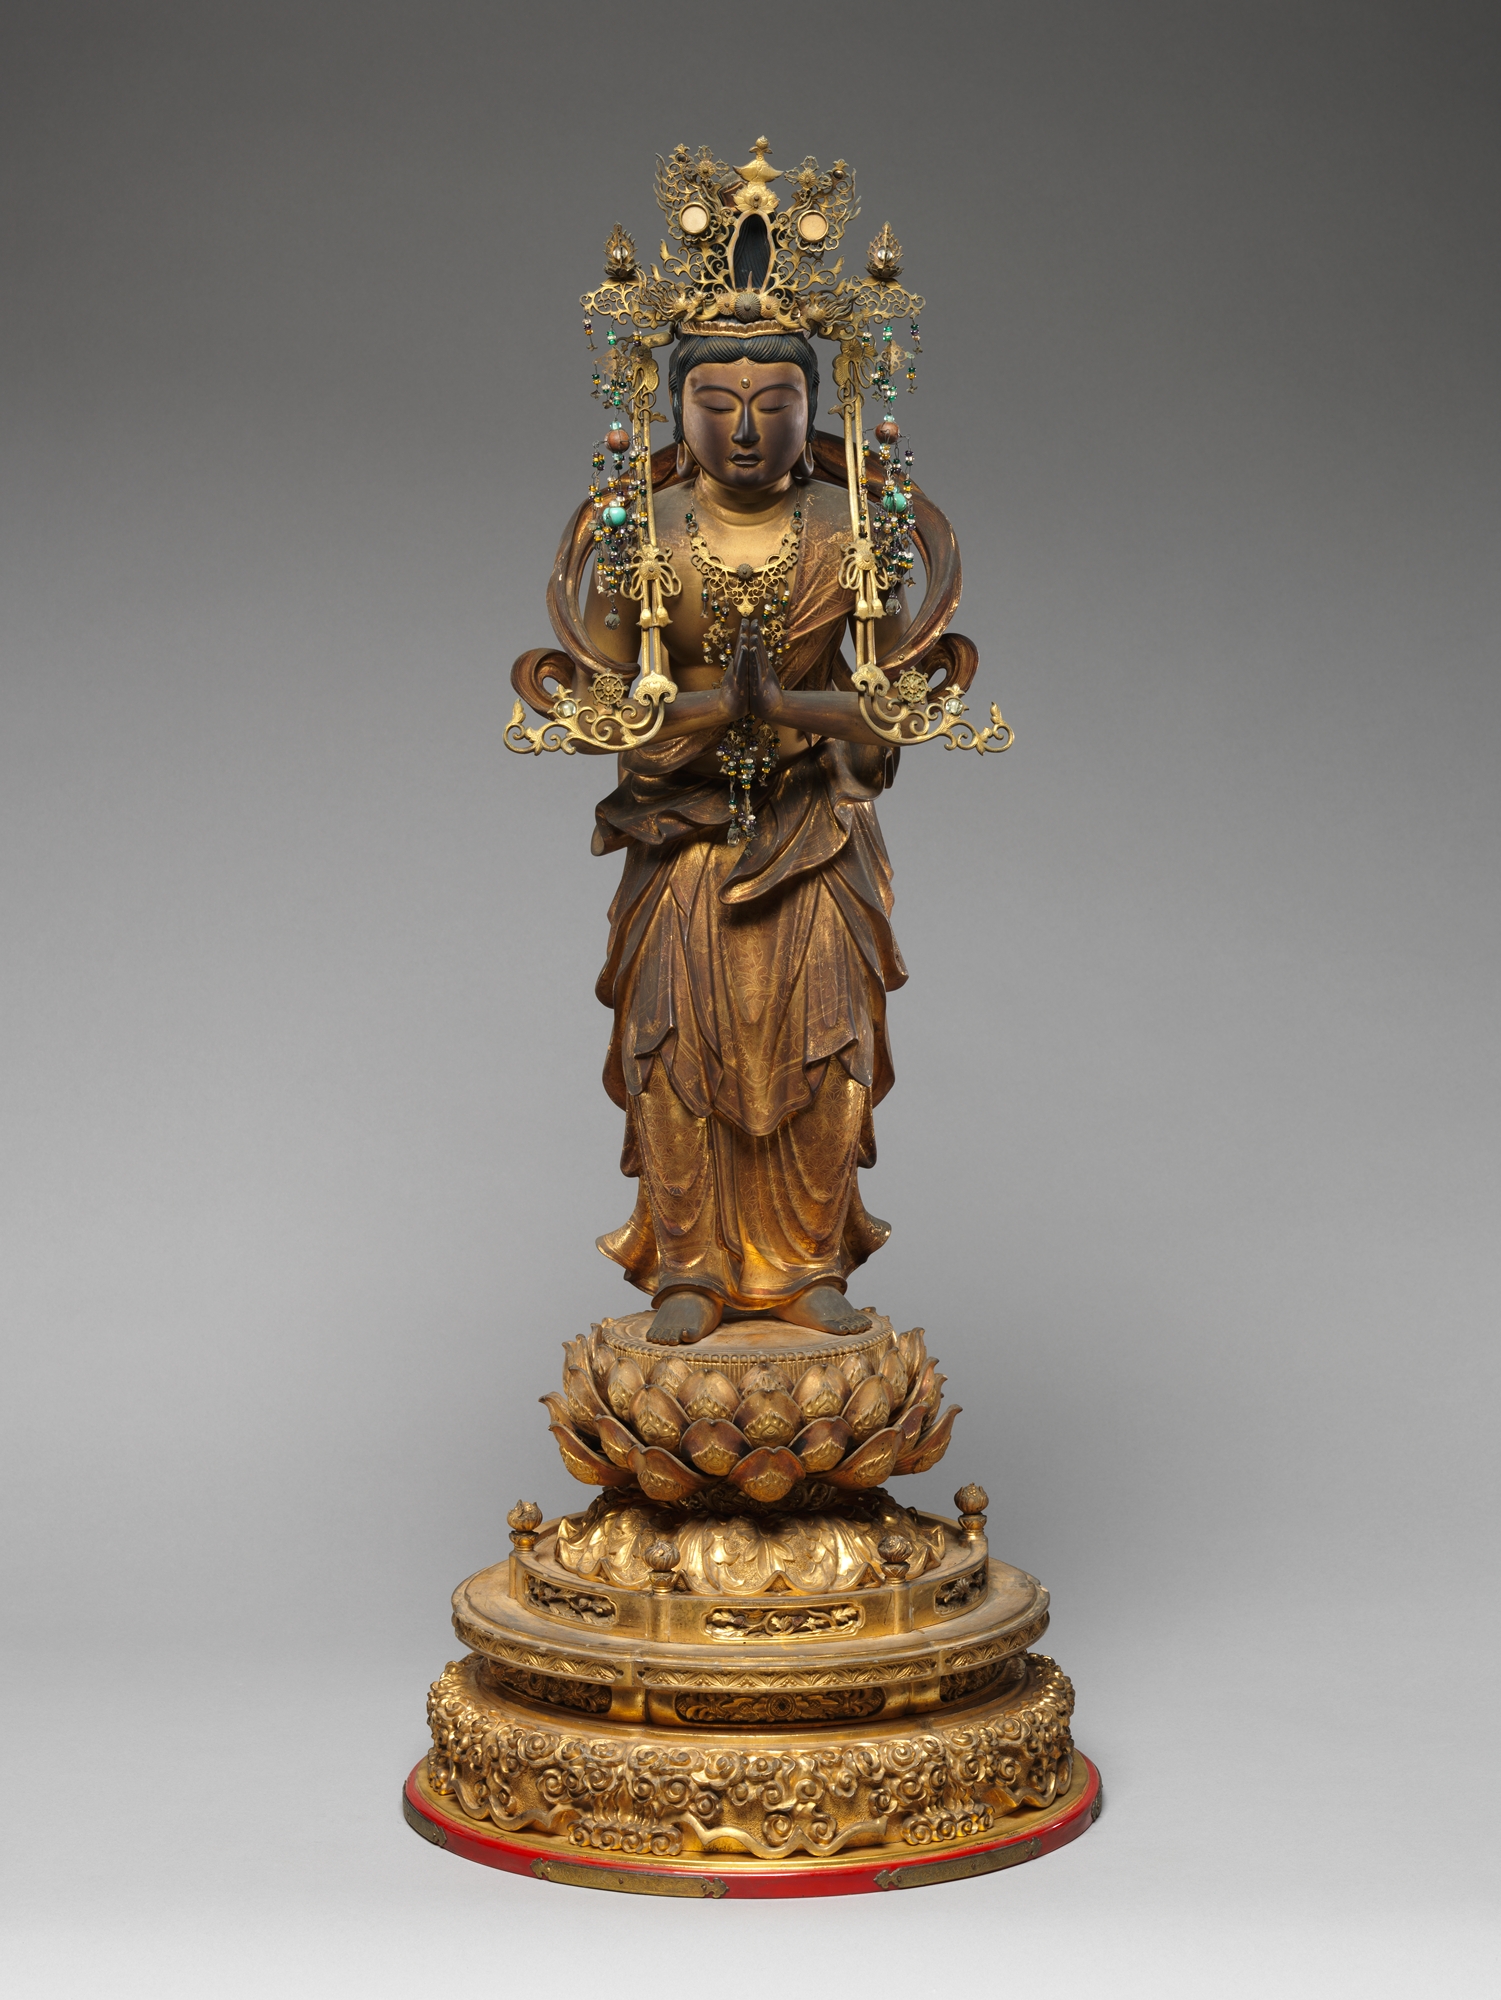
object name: figure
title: Bodhisattva Seishi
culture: japanese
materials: gold, gold leaf, lacquer, metal, wood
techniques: cutting, kirikane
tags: buddhism,bodhisattvas